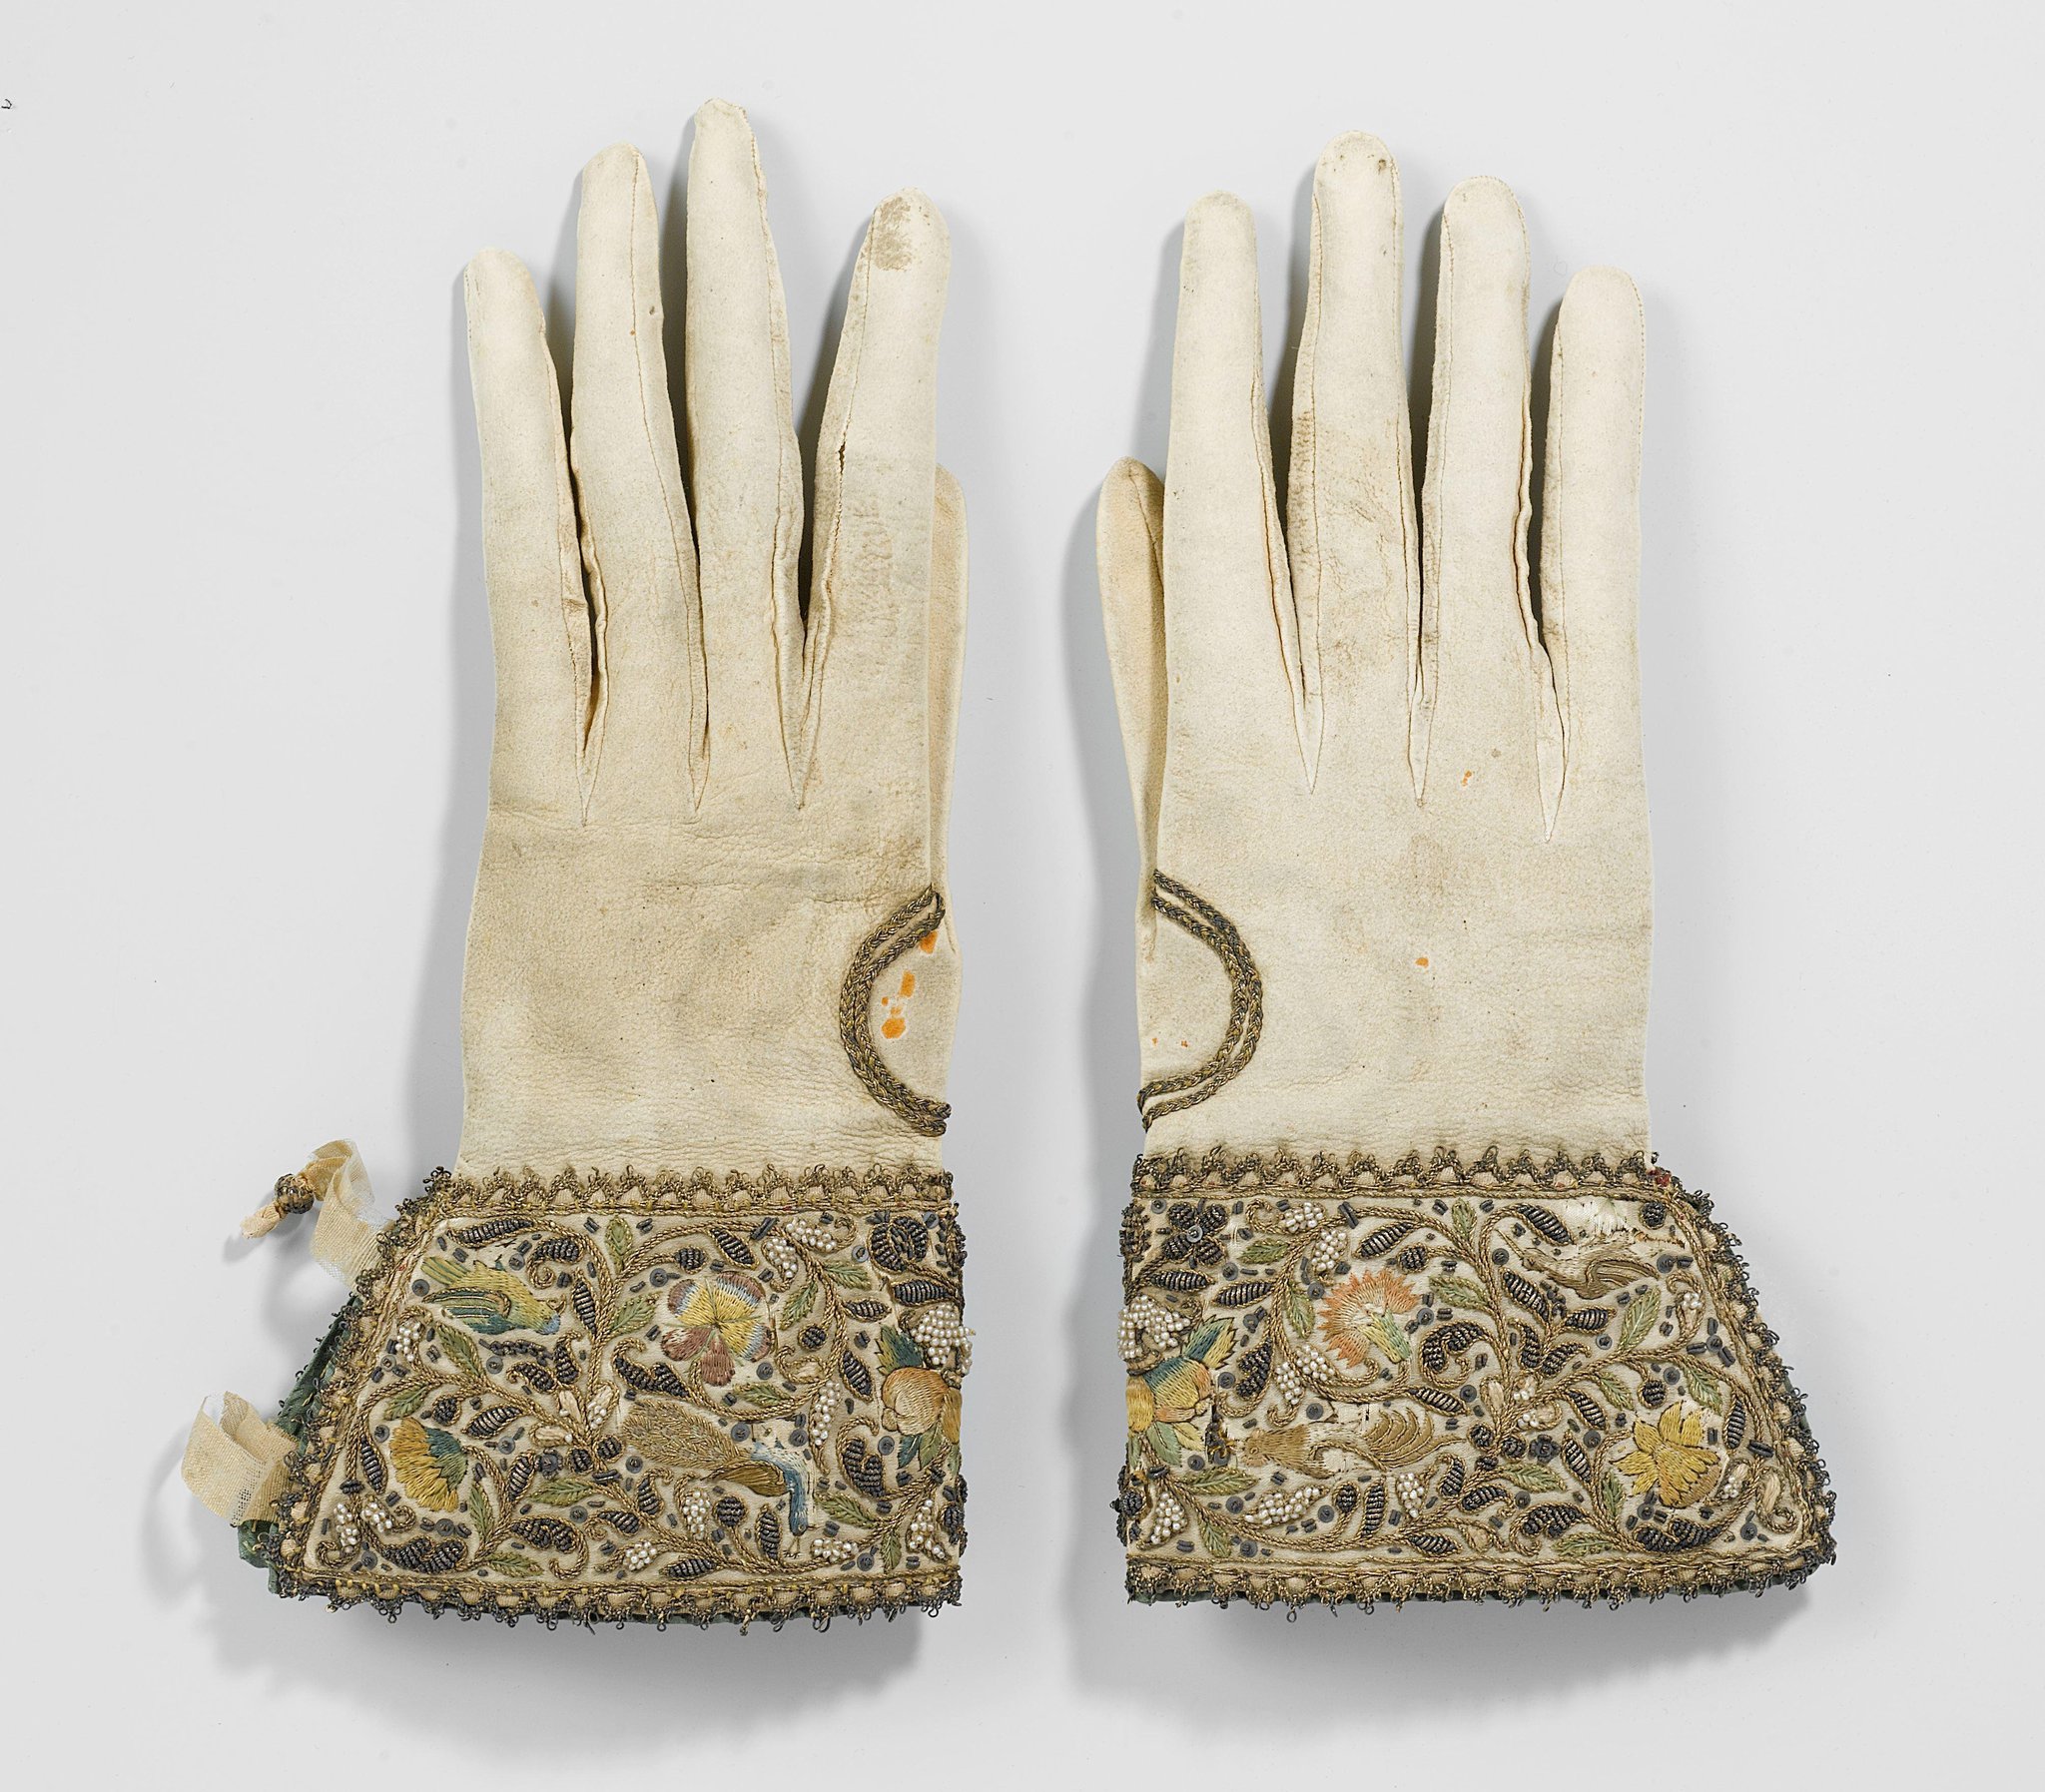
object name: bruidshandschoen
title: Handschoen van geitenleer met kappen van crèmekleurige satijn geborduurd met veelkleurige zijde, verguld zilverdraad, lovers en zoetwater parels, afgezet met goudkant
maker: Anonymous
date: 1600-1625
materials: pearl, leather, gold thread, silk, thread, wood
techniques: cutting, embroidered, spinning, tanning, weave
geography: northern netherlands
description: Handschoenen van geitenleer met kappen van crèmekleurige satijn geborduurd met veelkleurige zijde, verguld zilverdraad, lovers en zoetwater parels, afgezet met goudkant. Model: de handschoenen hebben losse kappen, die zijn aangenaaid. De kappen zijn verstevigd, mogelijk met dik papier. Het handdeel, dat van zacht leer is met de ruwe zijde aan de buitenkant, is ongevoerd. De kappen zijn gevoerd met groene zijde. Versiering: Rond de duimen zijn twee smalle banden van gevlochten verguld zilverdraad aangebracht. De kappen zijn aan de buitenkant bedekt met satijn waarop in reliëf is geborduurd. Op de vouw is een hoorn des overvloeds (cornucopia) van parels geplaatst, gevuld met vruchten en bladeren in satijnsteek waarboven een viooltje en een granaatappel met viooltje eronder, alle in zilverdraad. Hieruit ontstaan ingewikkelde florale meanders in zilverdraad en lovers waarin links een vogel met lange staartvleugels (haan?), een voorover buigende vogel met een lange snavel, een anjer en narcis; rechts een pauw, een vogel met een gekromde snavel (goudvink?), een viooltje en een onbekende bloem, all in satijnsteek. De kappen zijn afgezet met een smalle rand goudkant. Op de linkerkap bevinden zich restanten van crèmekleurige satijnen linten, waar oorspronkelijk kleine zilveren balletjes - waarvan één is bewaard gebleven - aan hingen.